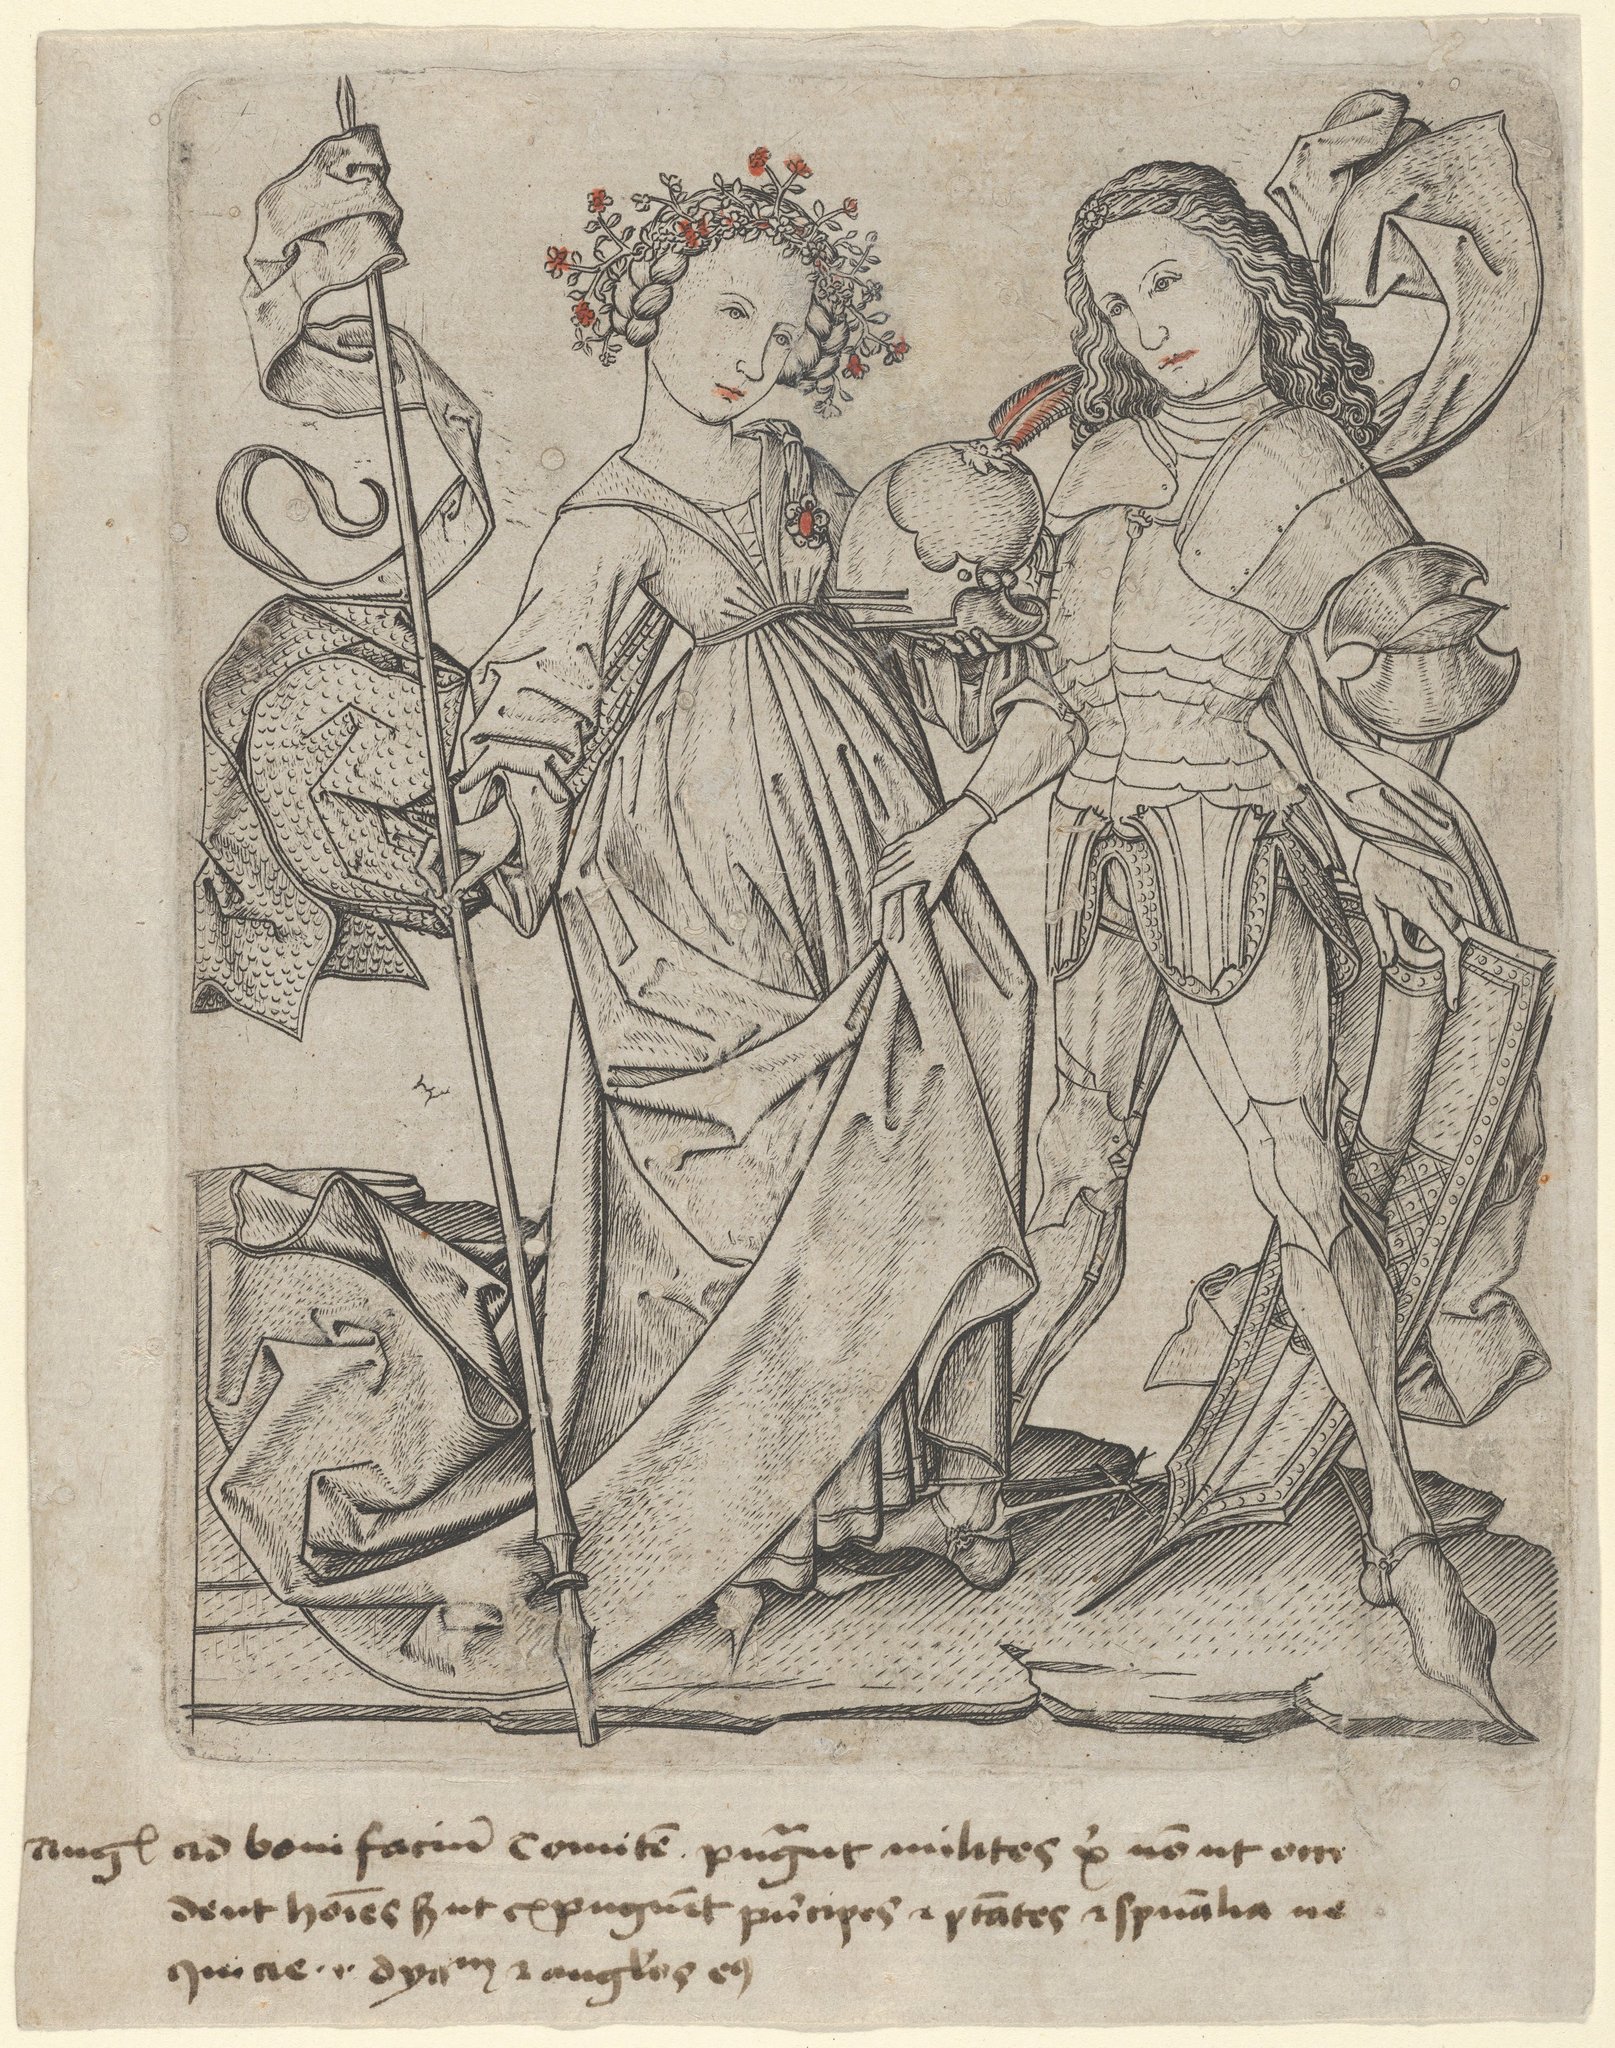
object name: print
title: The Knight and the Lady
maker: master es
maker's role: artist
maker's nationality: german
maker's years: 1445-1467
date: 1401-1500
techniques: engraving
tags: women,knights